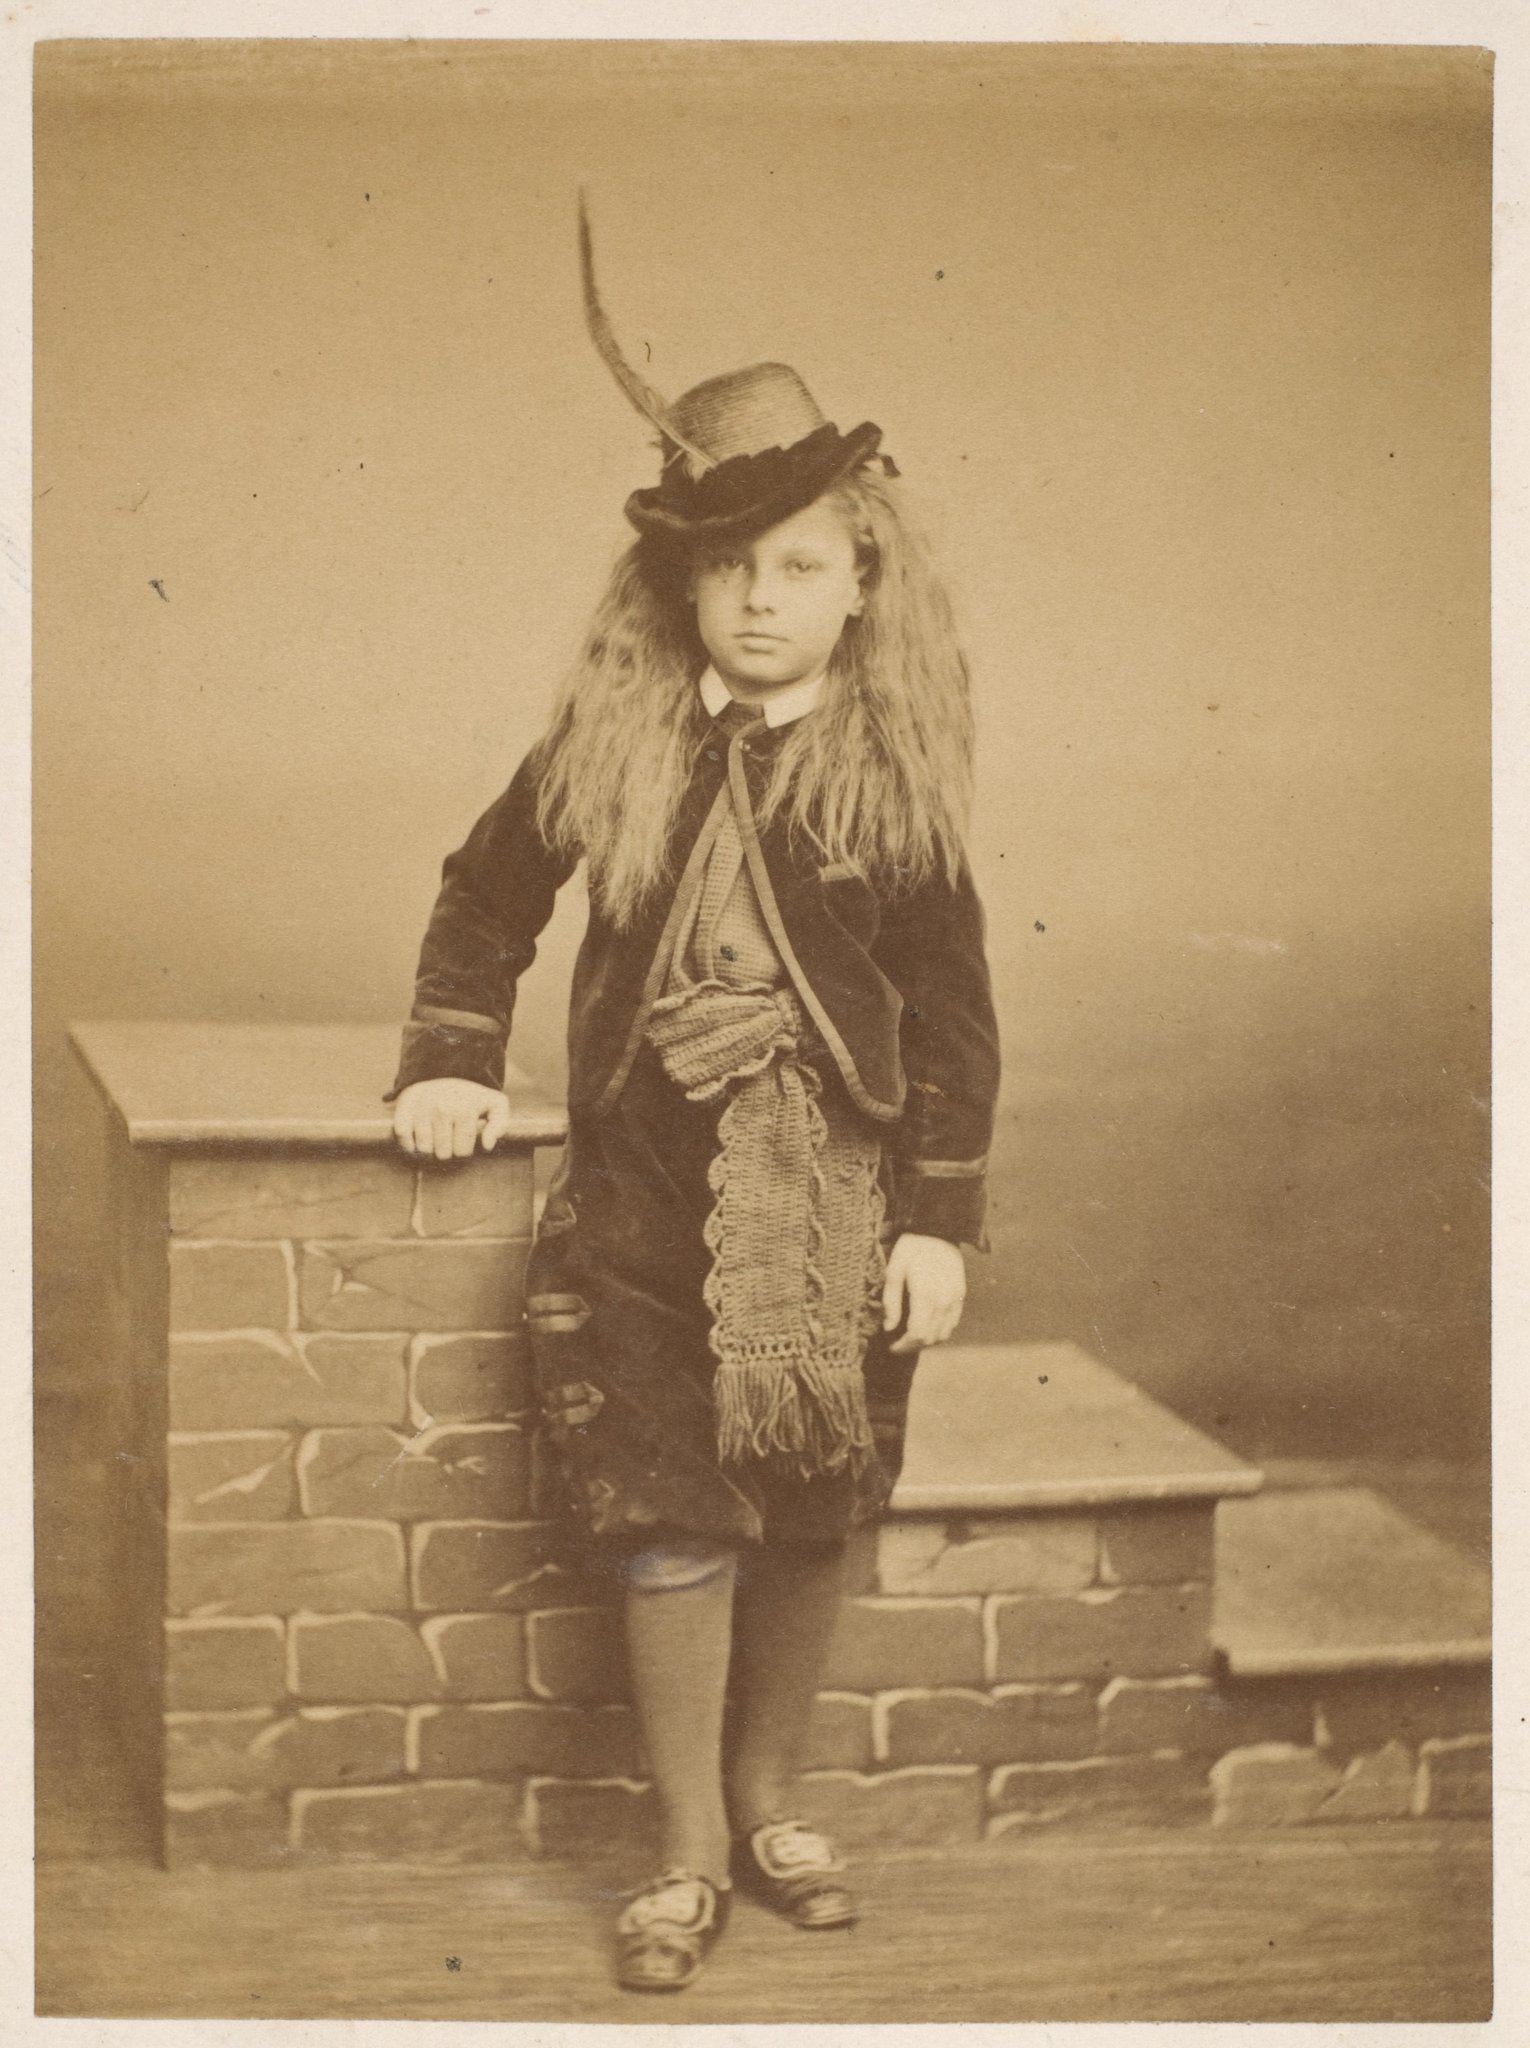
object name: photograph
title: Le montagnard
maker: pierre-louis pierson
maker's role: artist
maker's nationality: french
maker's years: 1822-1913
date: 1860-1869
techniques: albumen silver print, glass negative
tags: girls,portraits